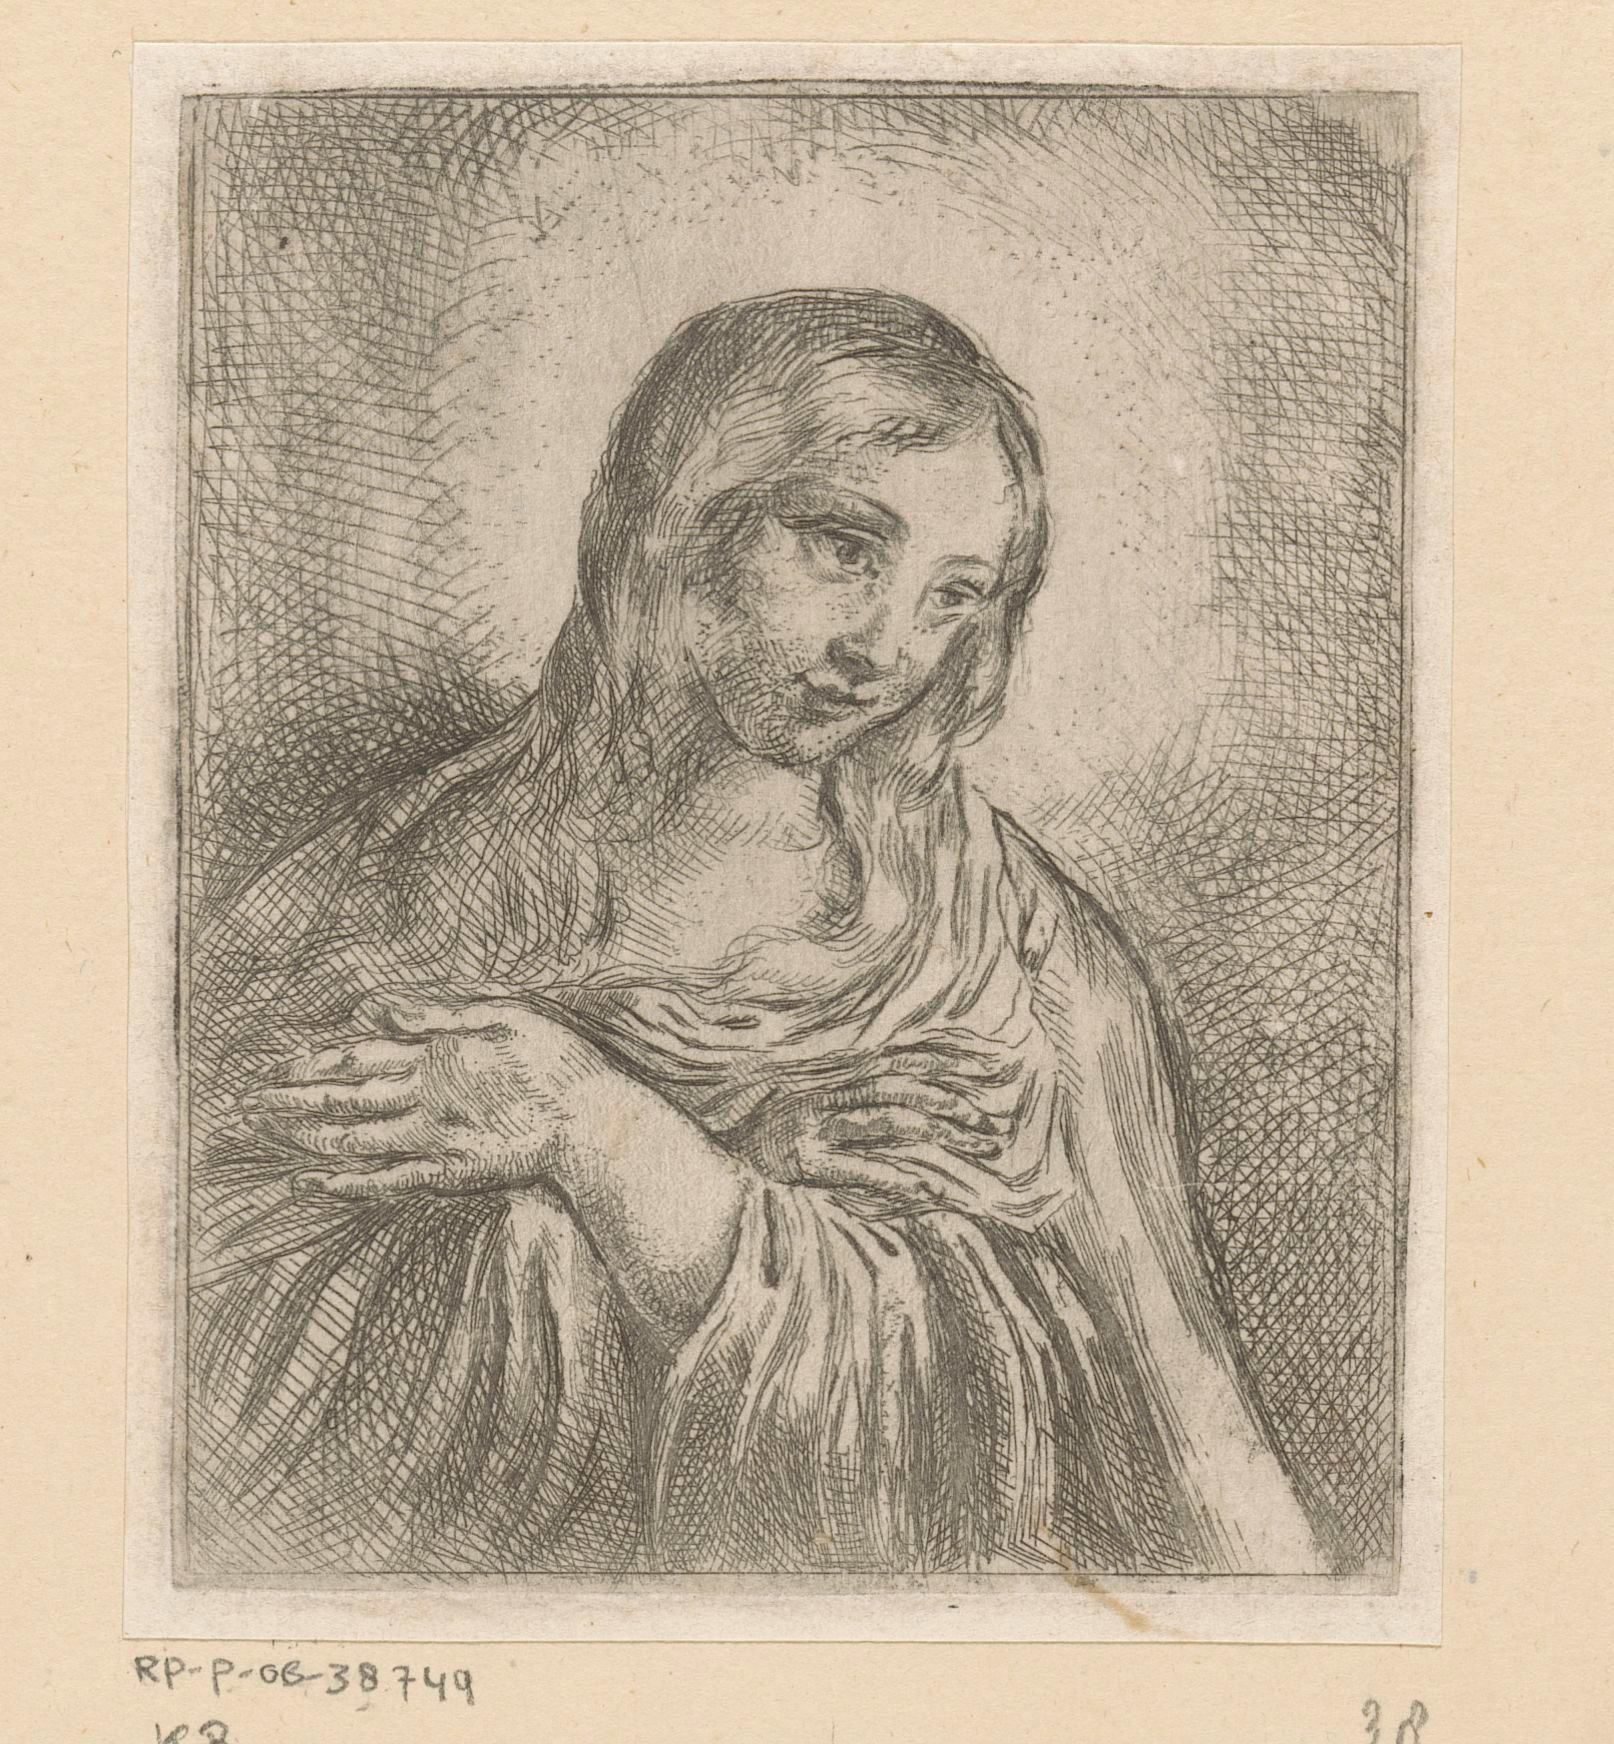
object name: print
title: Maria Magdalena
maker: Anonymous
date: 1550-1649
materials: paper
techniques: etching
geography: italy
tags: the penitent harlot mary magdalene; possible attributes: book (or scroll), crown, crown of thorns, crucifix, jar of ointment, mirror, musical instrument, palm-branch, rosary, scourge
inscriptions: collector's mark: Lugt 240